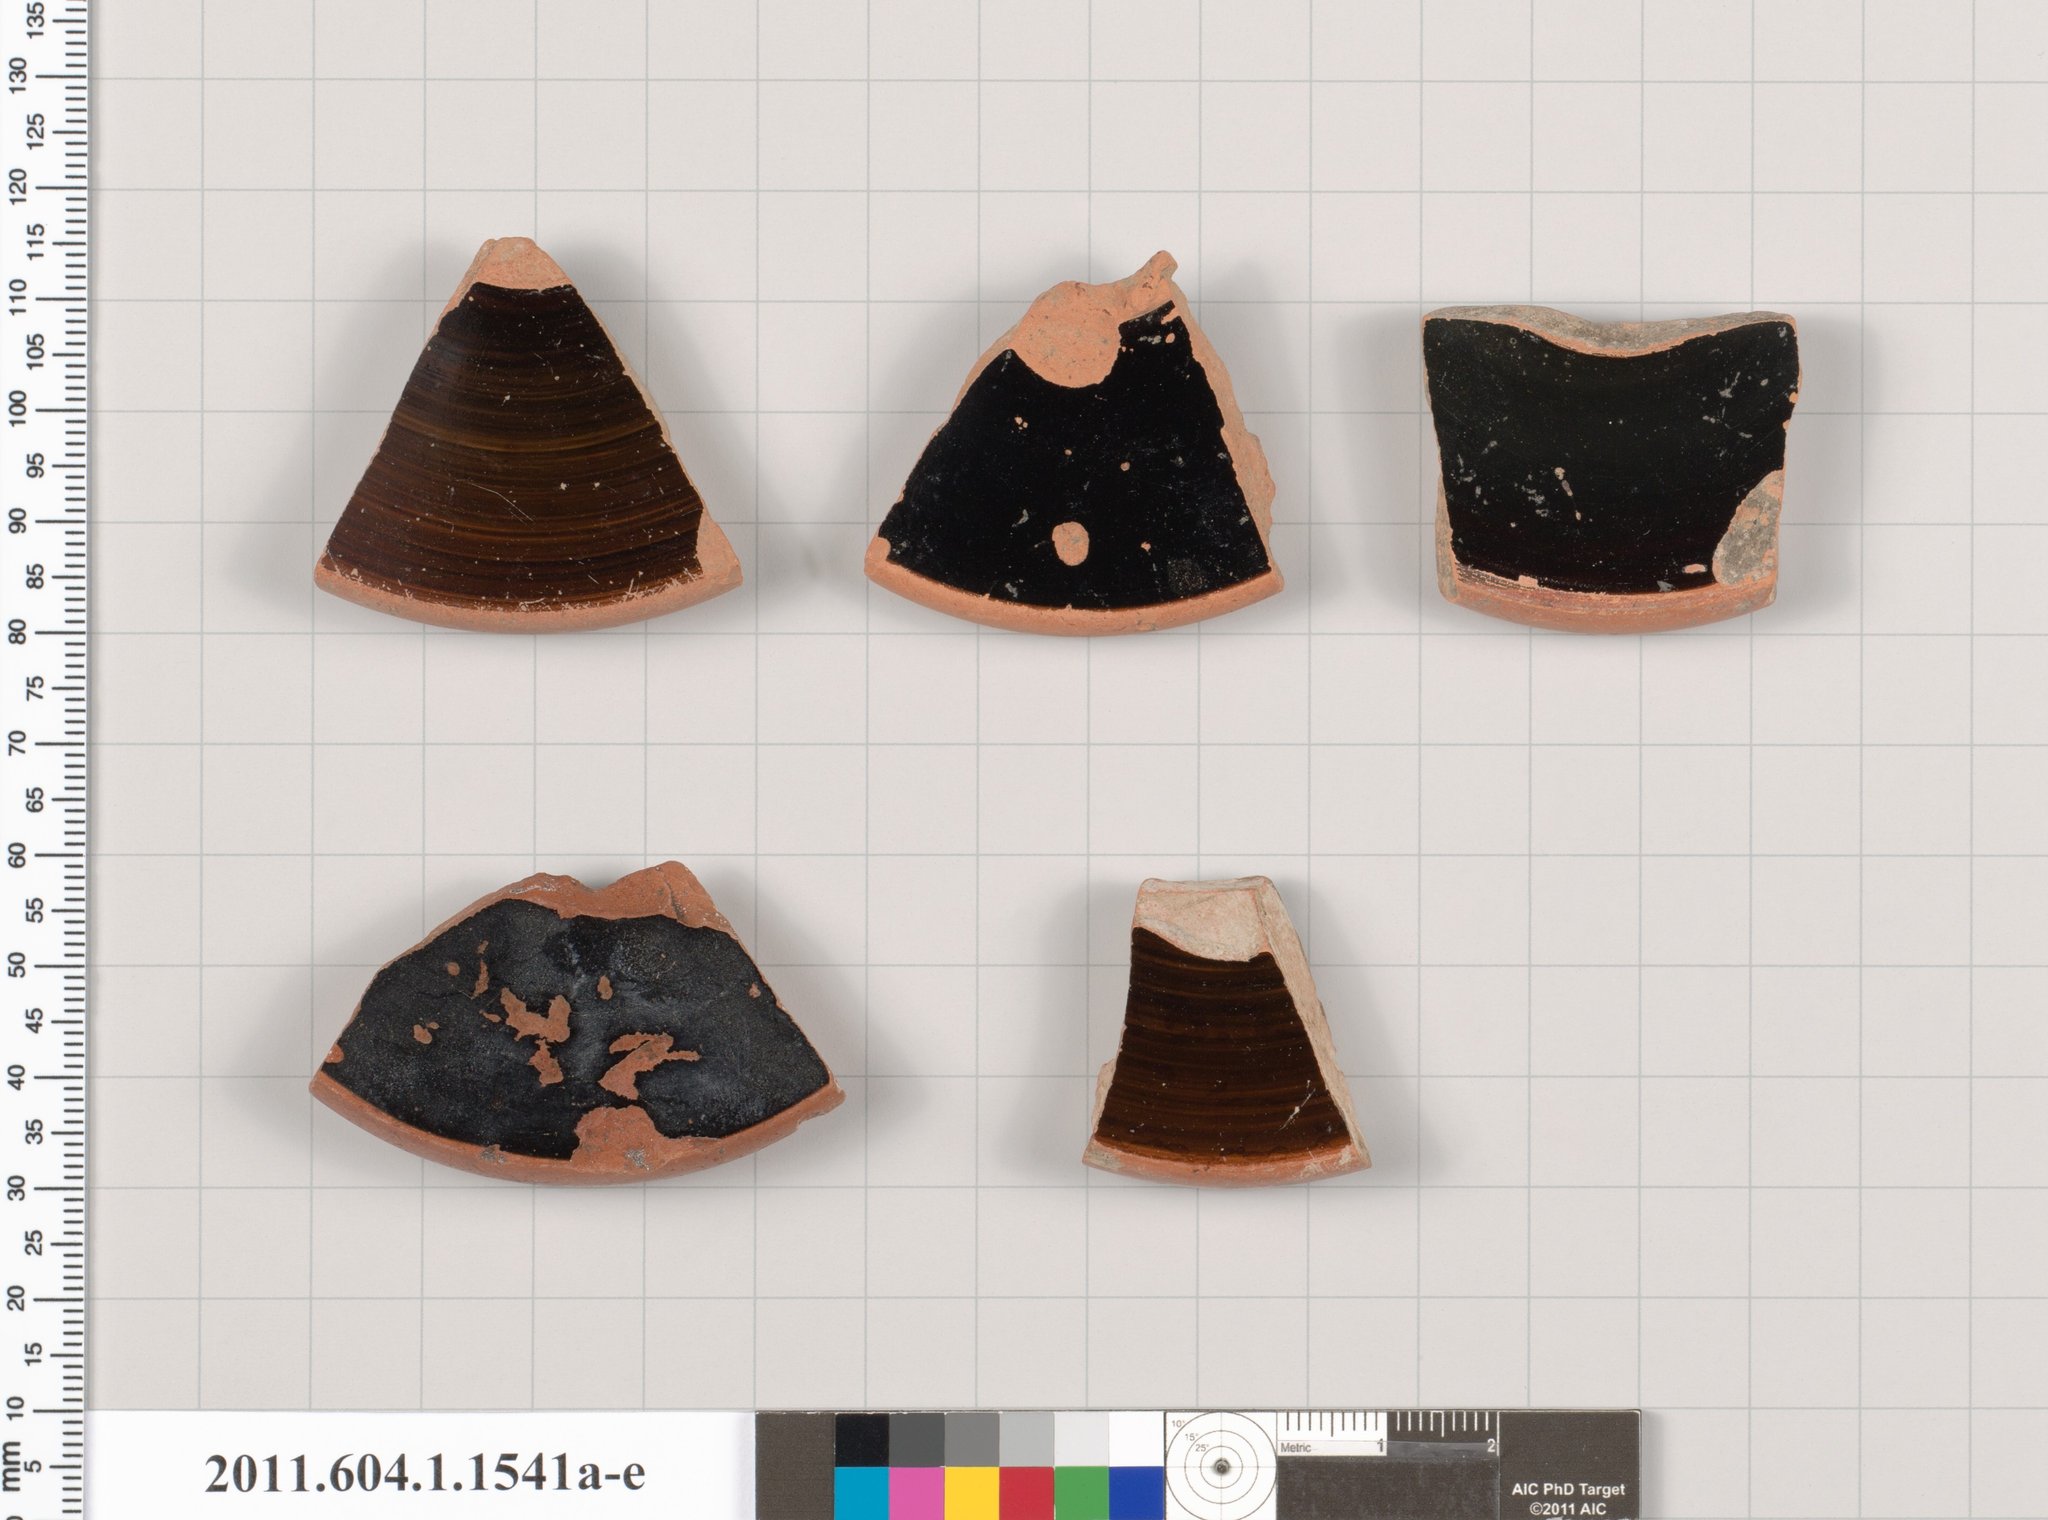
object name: kylix fragment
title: Terracotta fragments of kylikes (drinking cups)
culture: greek, attic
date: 500-401 BCE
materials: terracotta